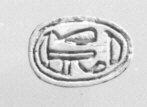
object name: stamp seal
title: Scarab seal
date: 1700-1560 BCE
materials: stone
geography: levant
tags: scarabs